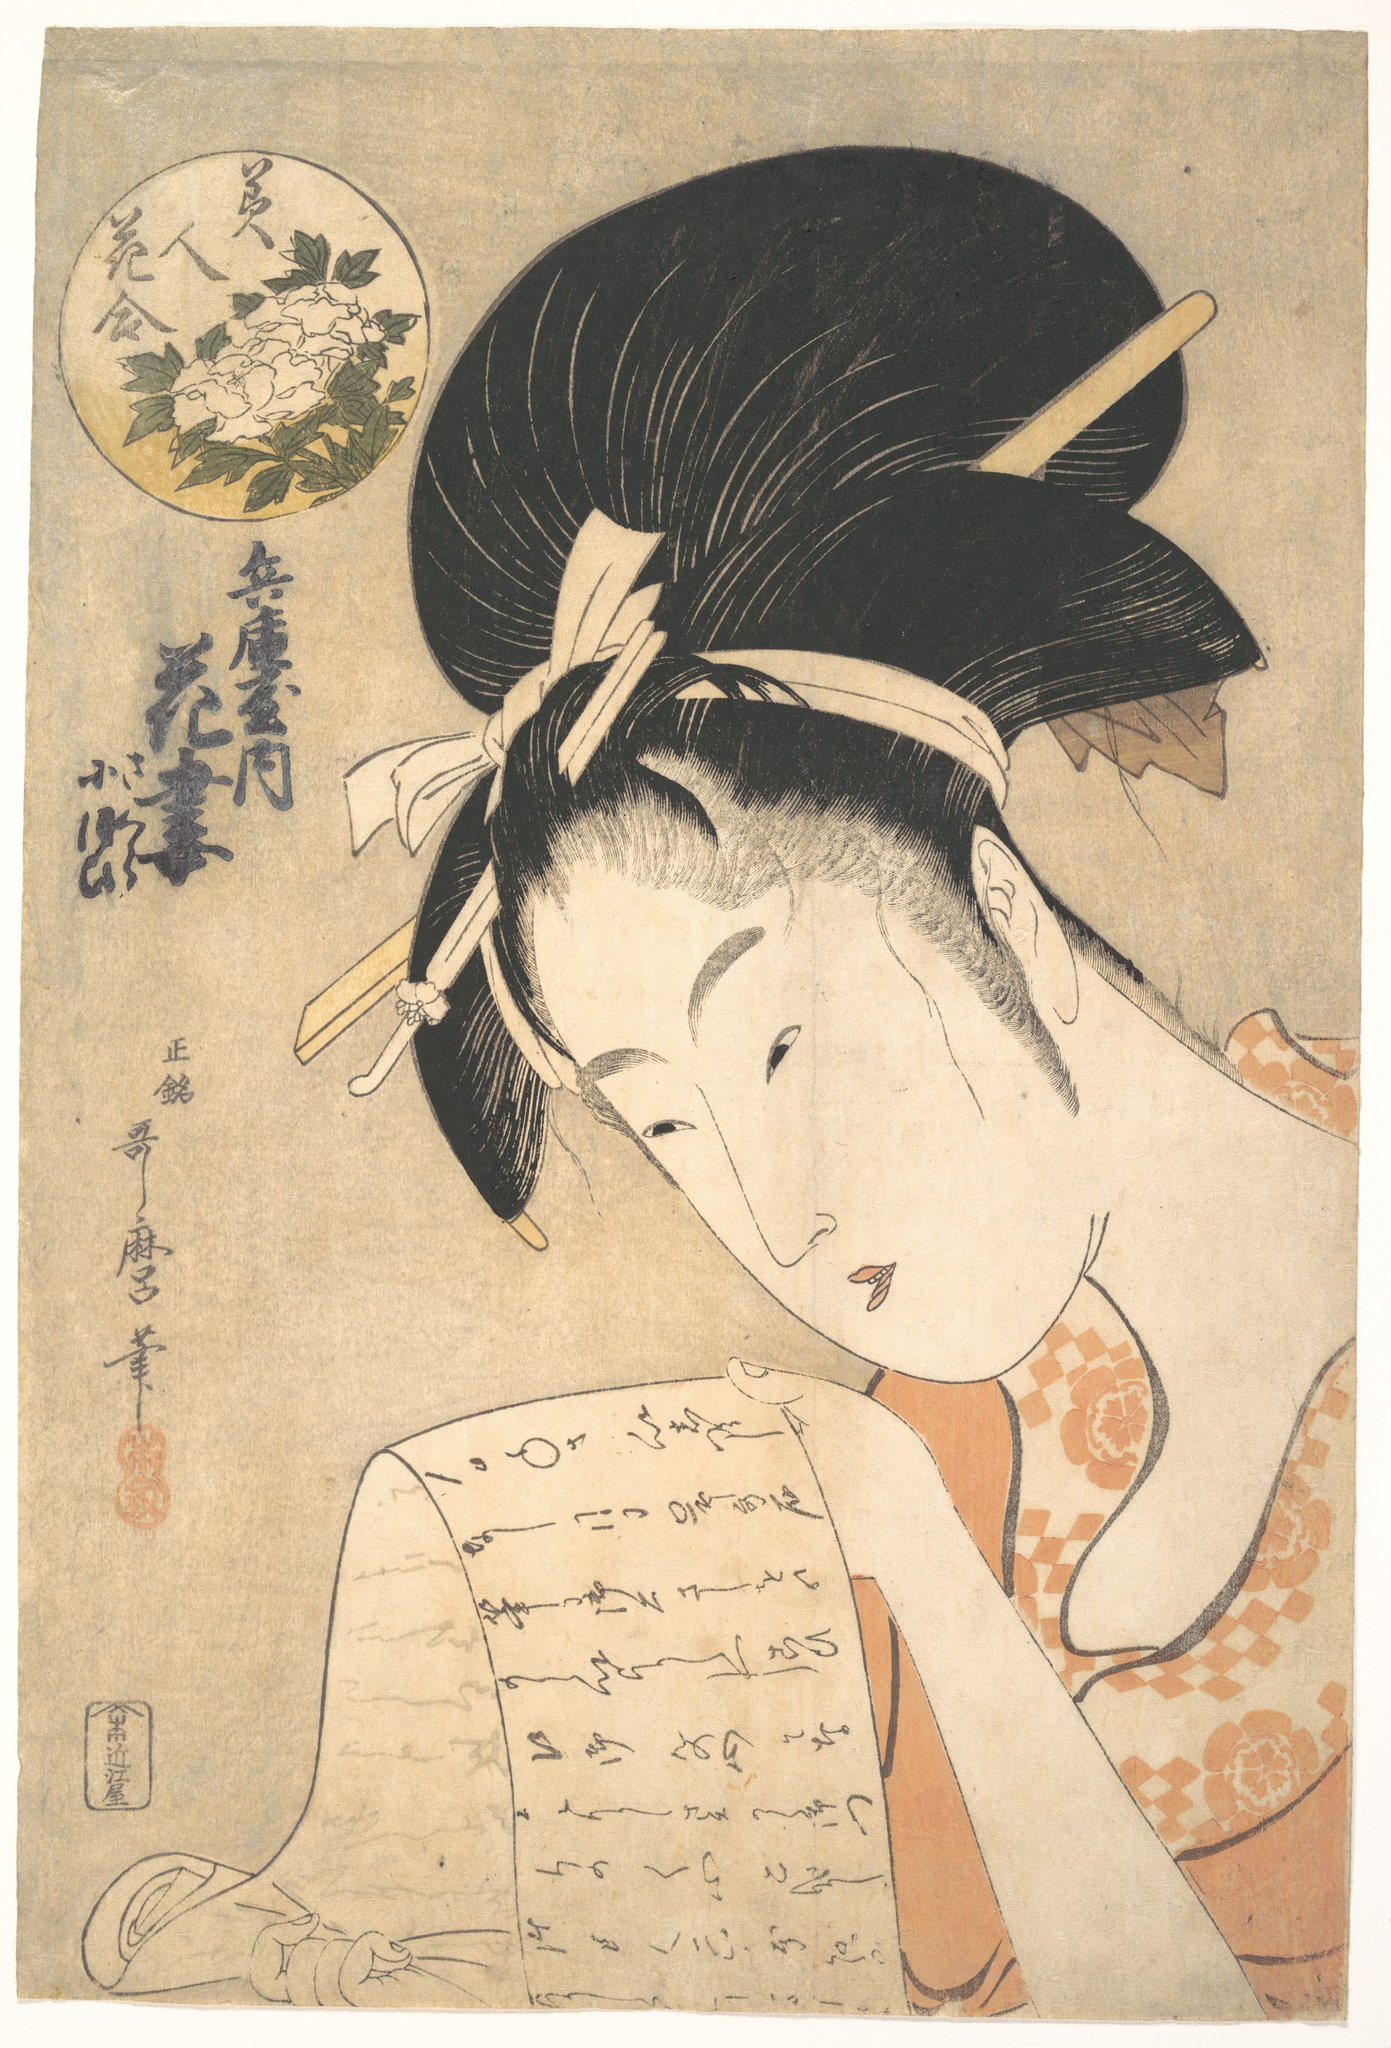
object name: print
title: “The Courtesan Hanazuma Reading a Letter,” from the series Beauties Compared to Flowers (Bijin hana awase)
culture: japanese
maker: kitagawa utamaro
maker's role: artist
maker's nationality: japanese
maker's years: 1754-1806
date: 1790-1799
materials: ink, paper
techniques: woodblock print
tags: women,reading